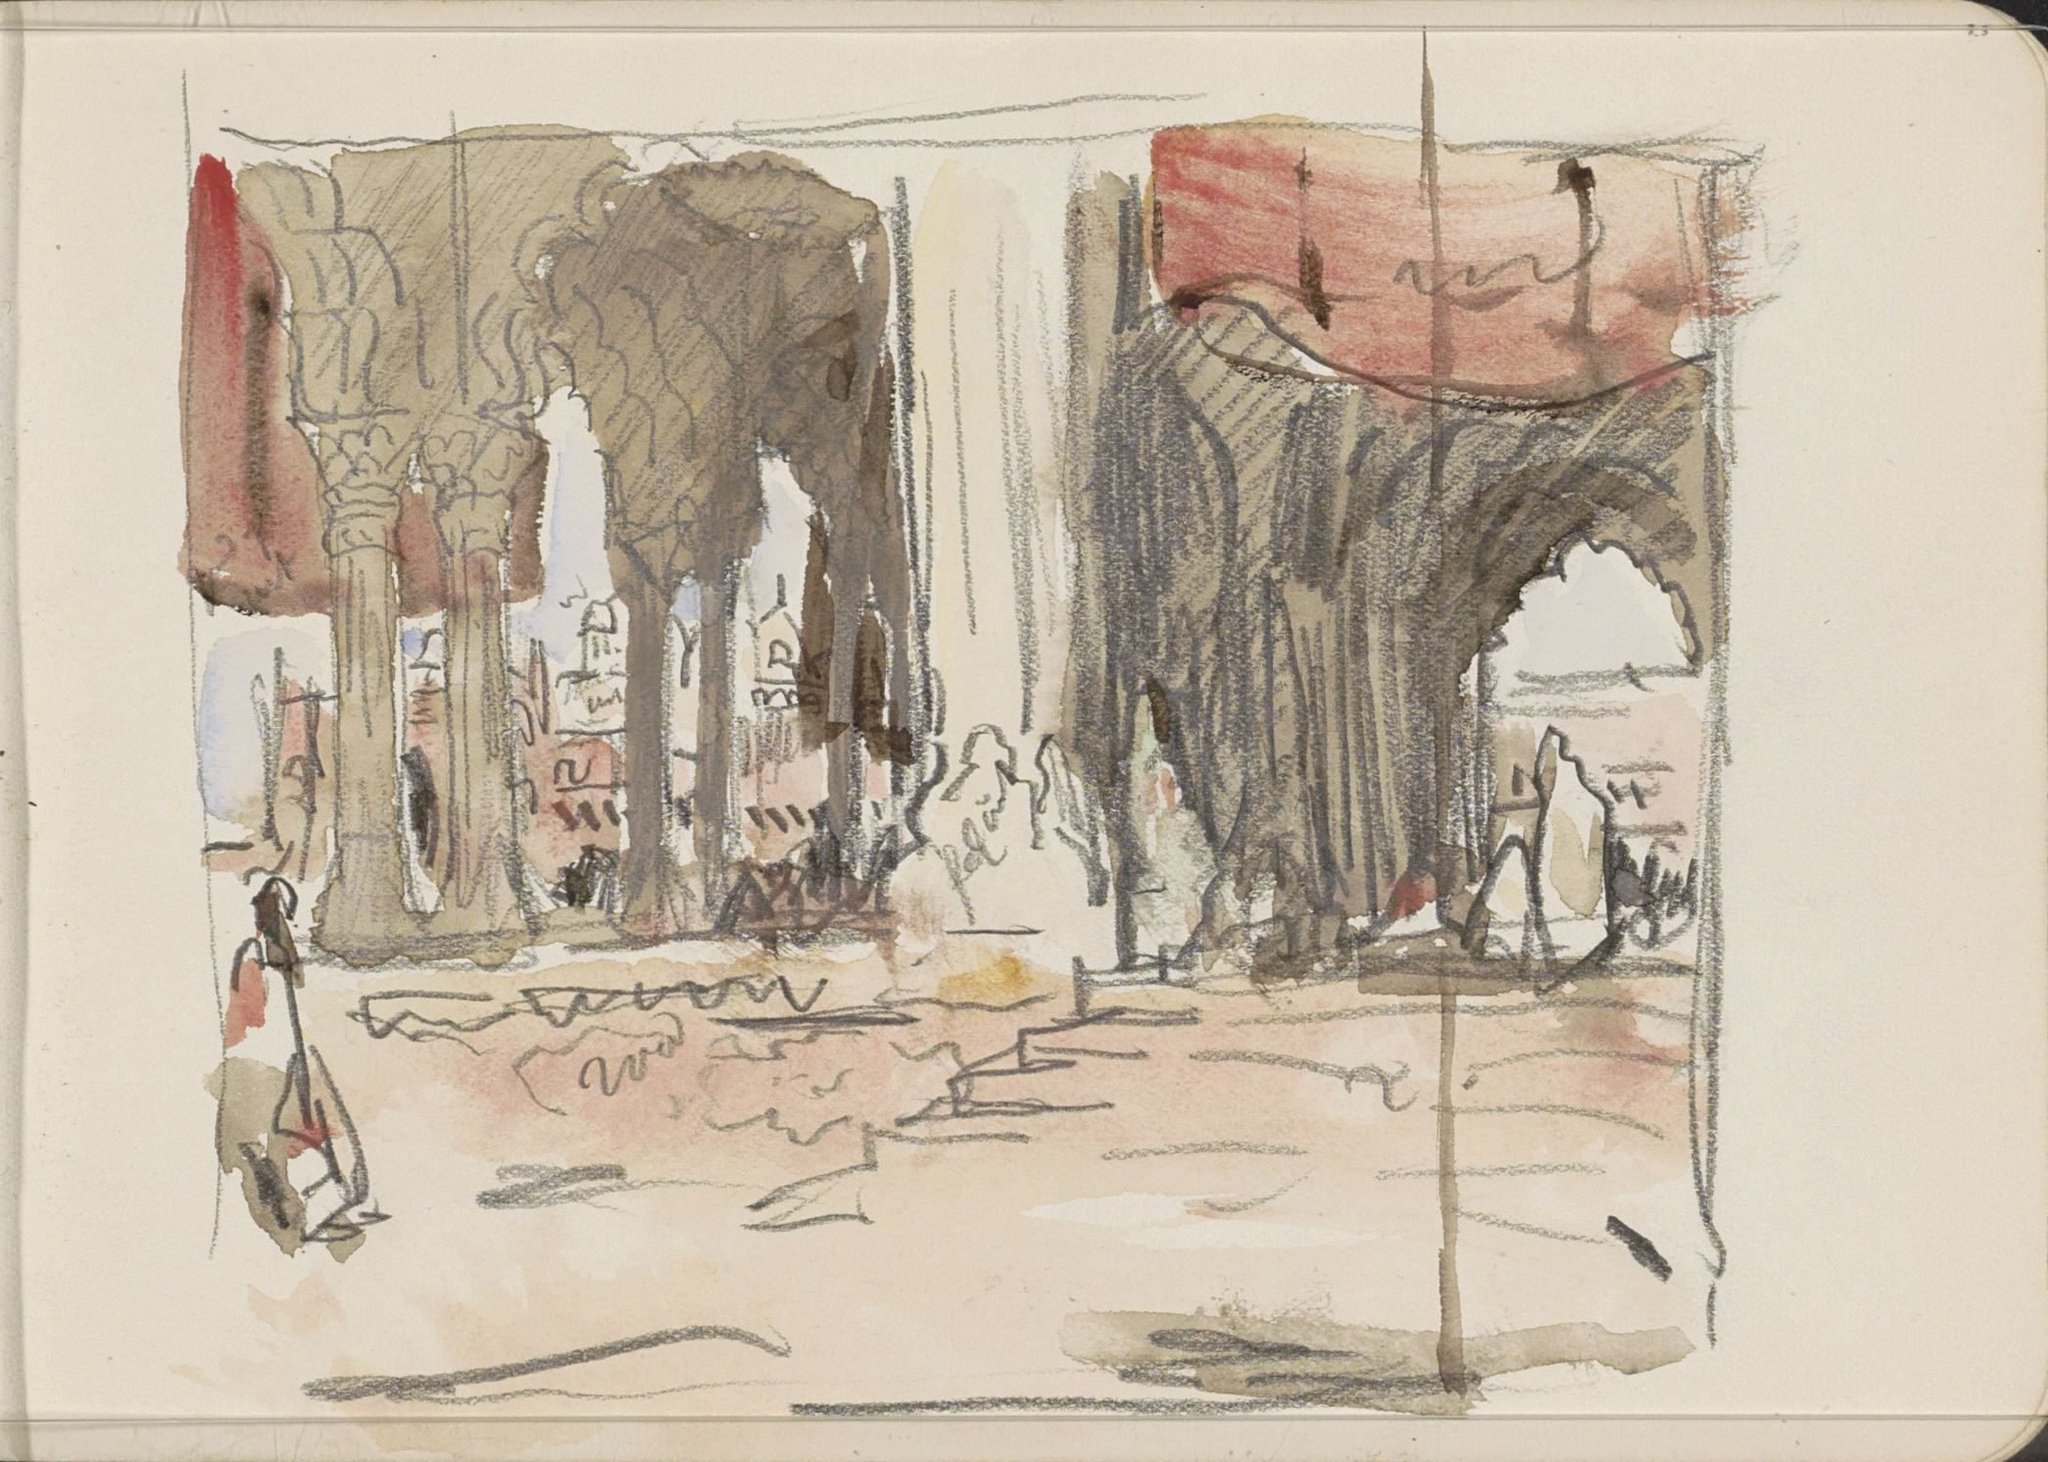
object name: sketchbook leaf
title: Zuilengalerij van de Jama Masjid Moskee in Delhi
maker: marius bauer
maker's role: draughtsman, print maker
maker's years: 1867-1932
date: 1925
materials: paper, pencil, watercolor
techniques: brush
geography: delhi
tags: colonnade, temple, shrine ~ islam, mohammedanism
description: Pagina 25 uit een schetsboek met 15 bladen.